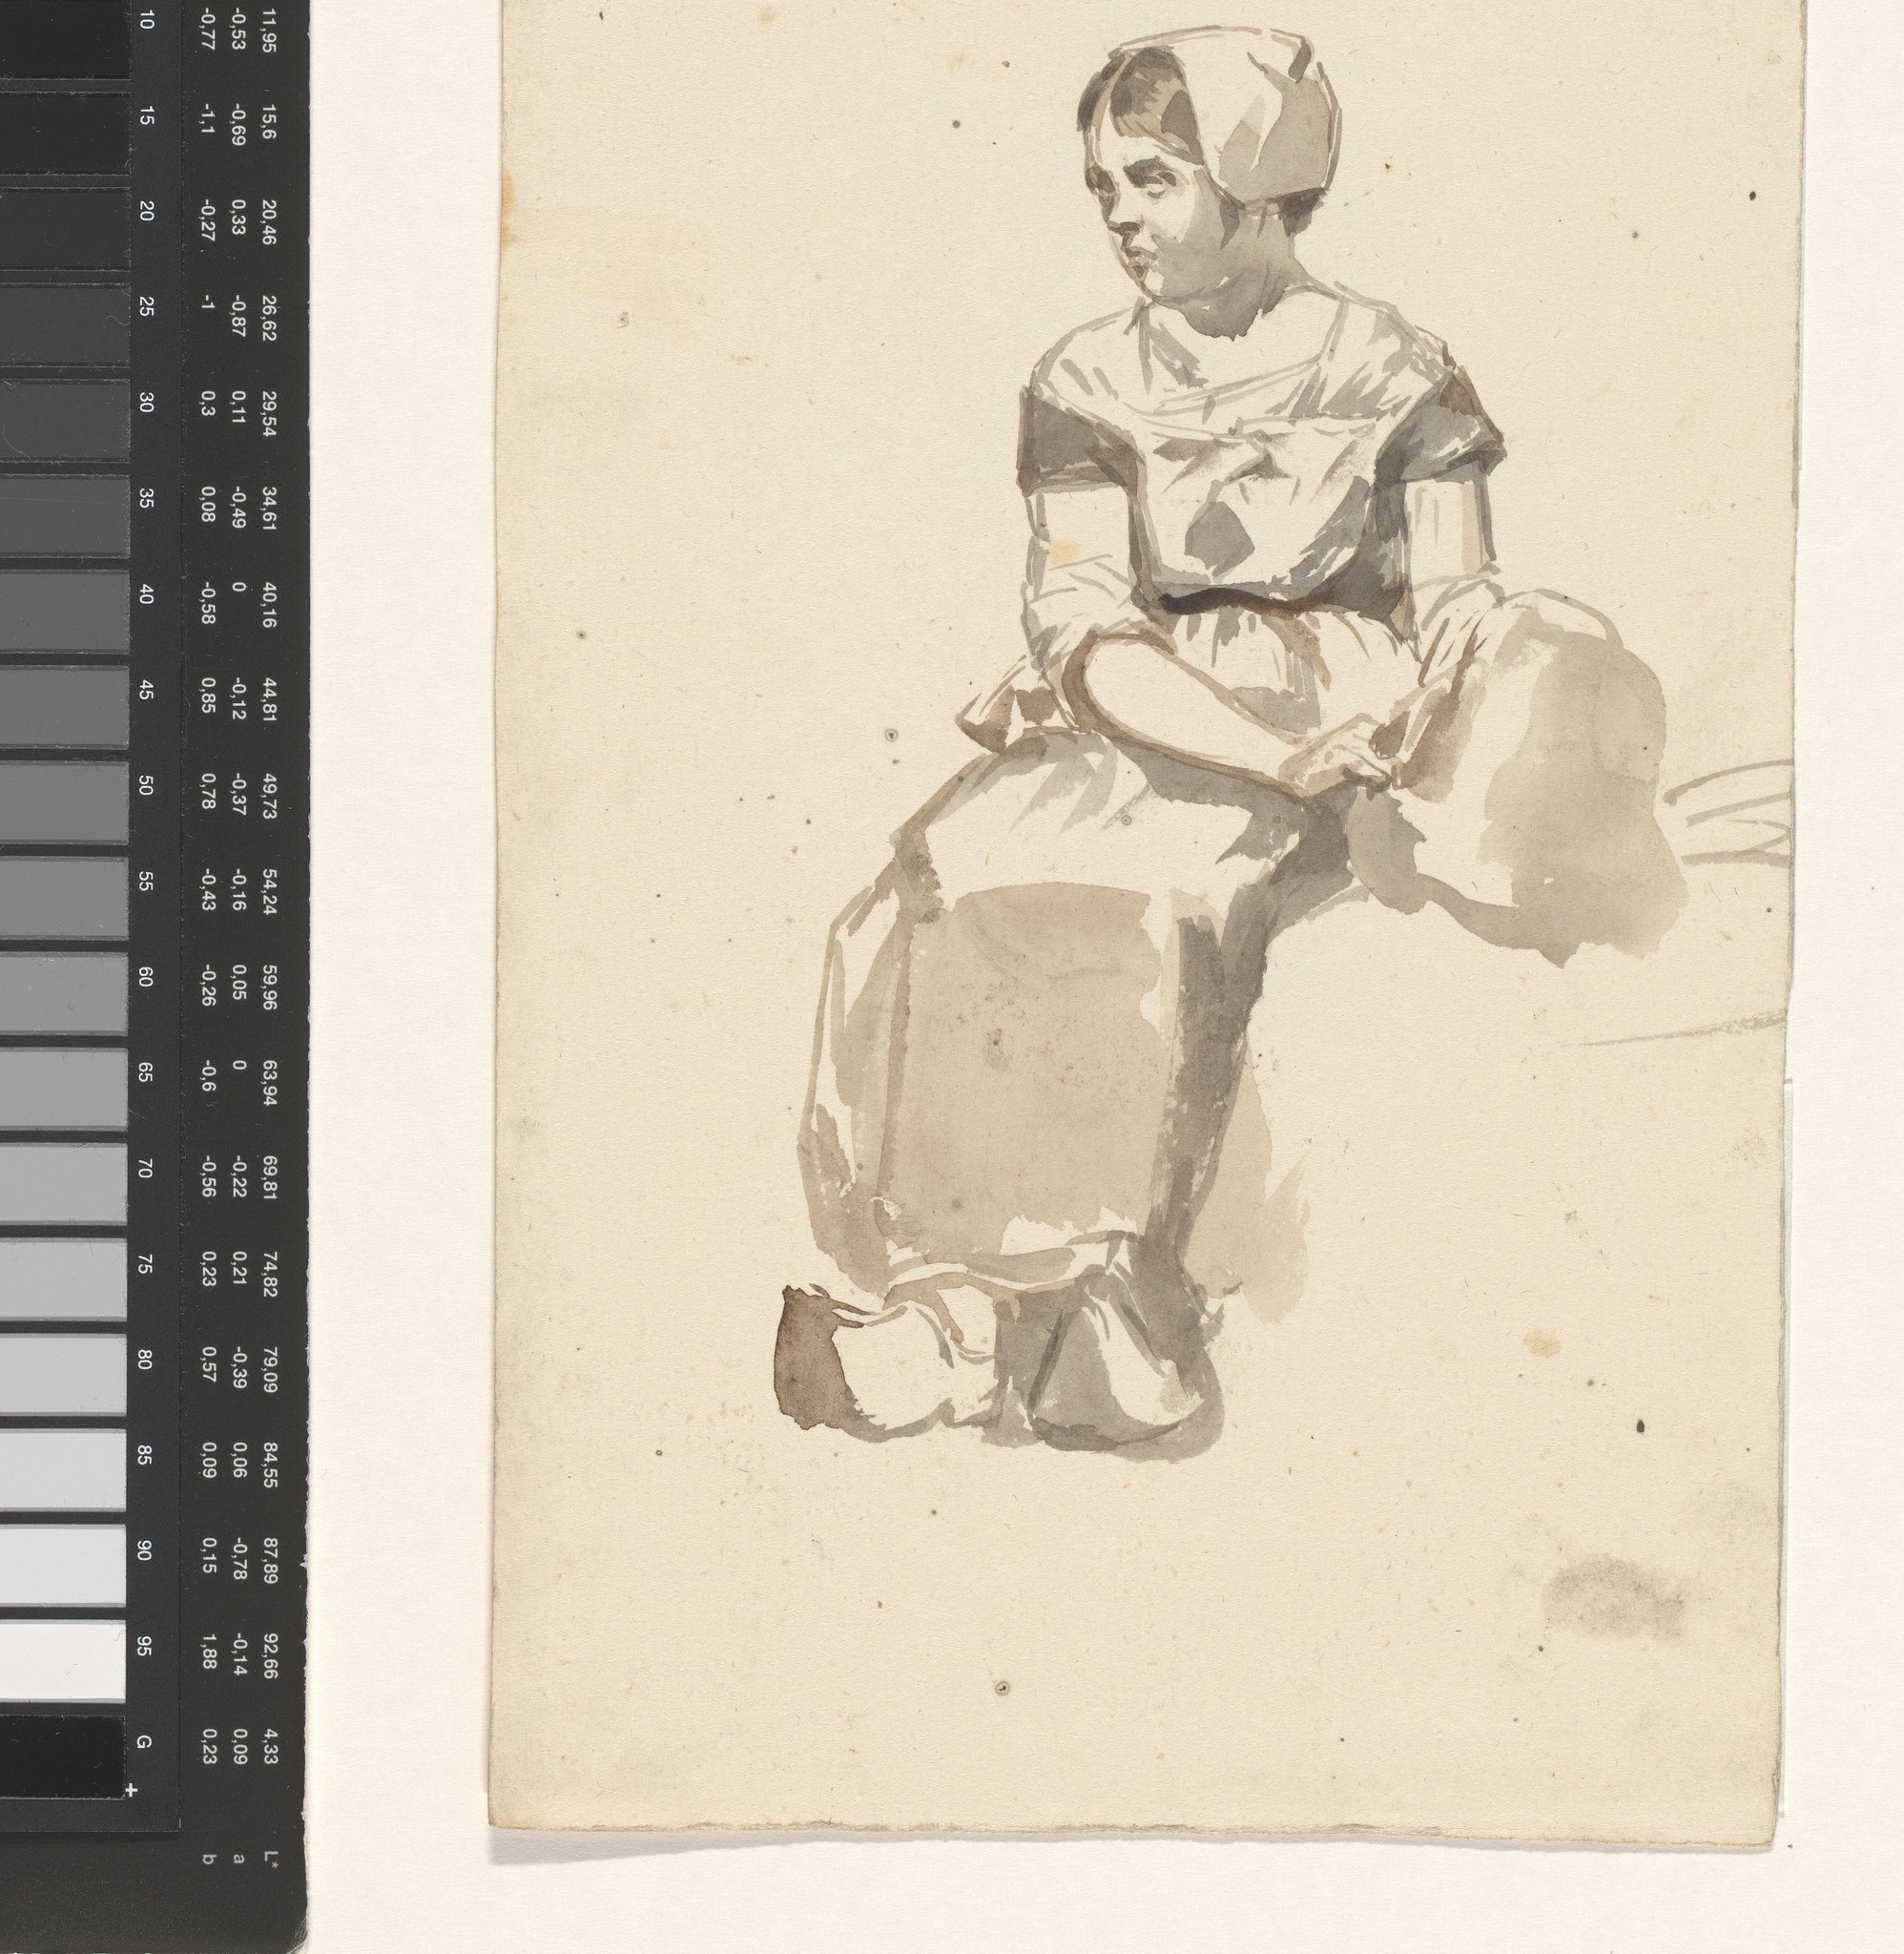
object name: drawing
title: Zittende vrouw met muts en klompen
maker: jan bedijs tom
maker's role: draughtsman, painter, print maker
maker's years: 1813-1894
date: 1823-1894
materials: ink, paper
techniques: brush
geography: the hague